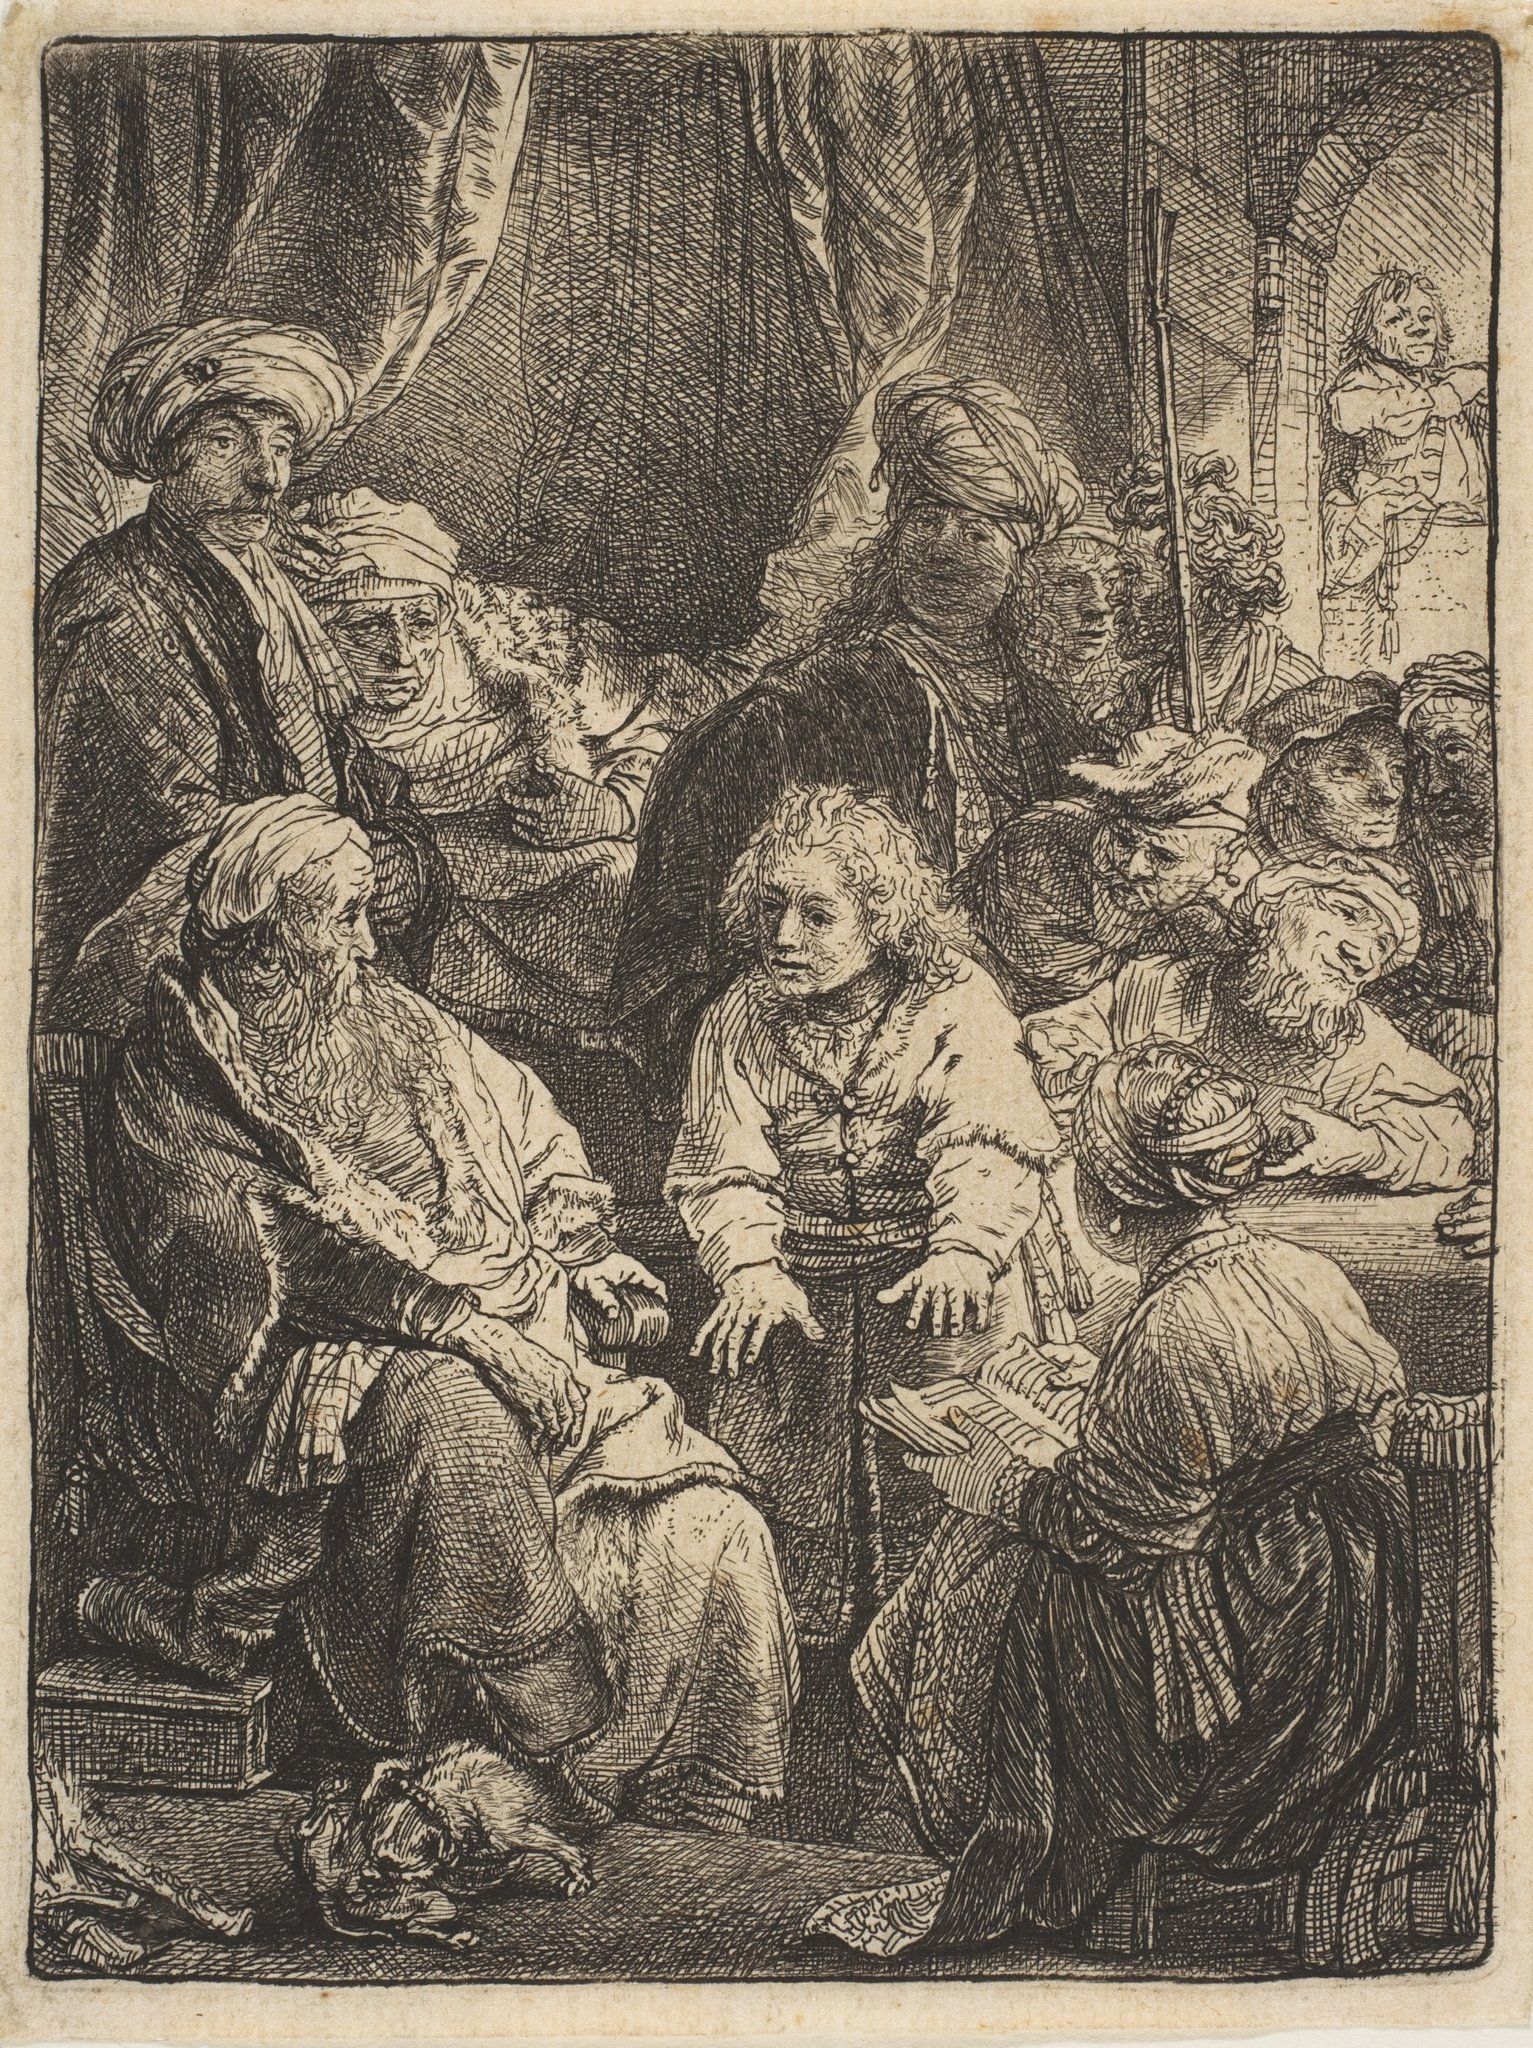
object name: print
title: Joseph Telling His Dreams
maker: rembrandt van rijn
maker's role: artist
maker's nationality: dutch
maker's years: 1606-1669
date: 1638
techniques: etching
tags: animals,men,women